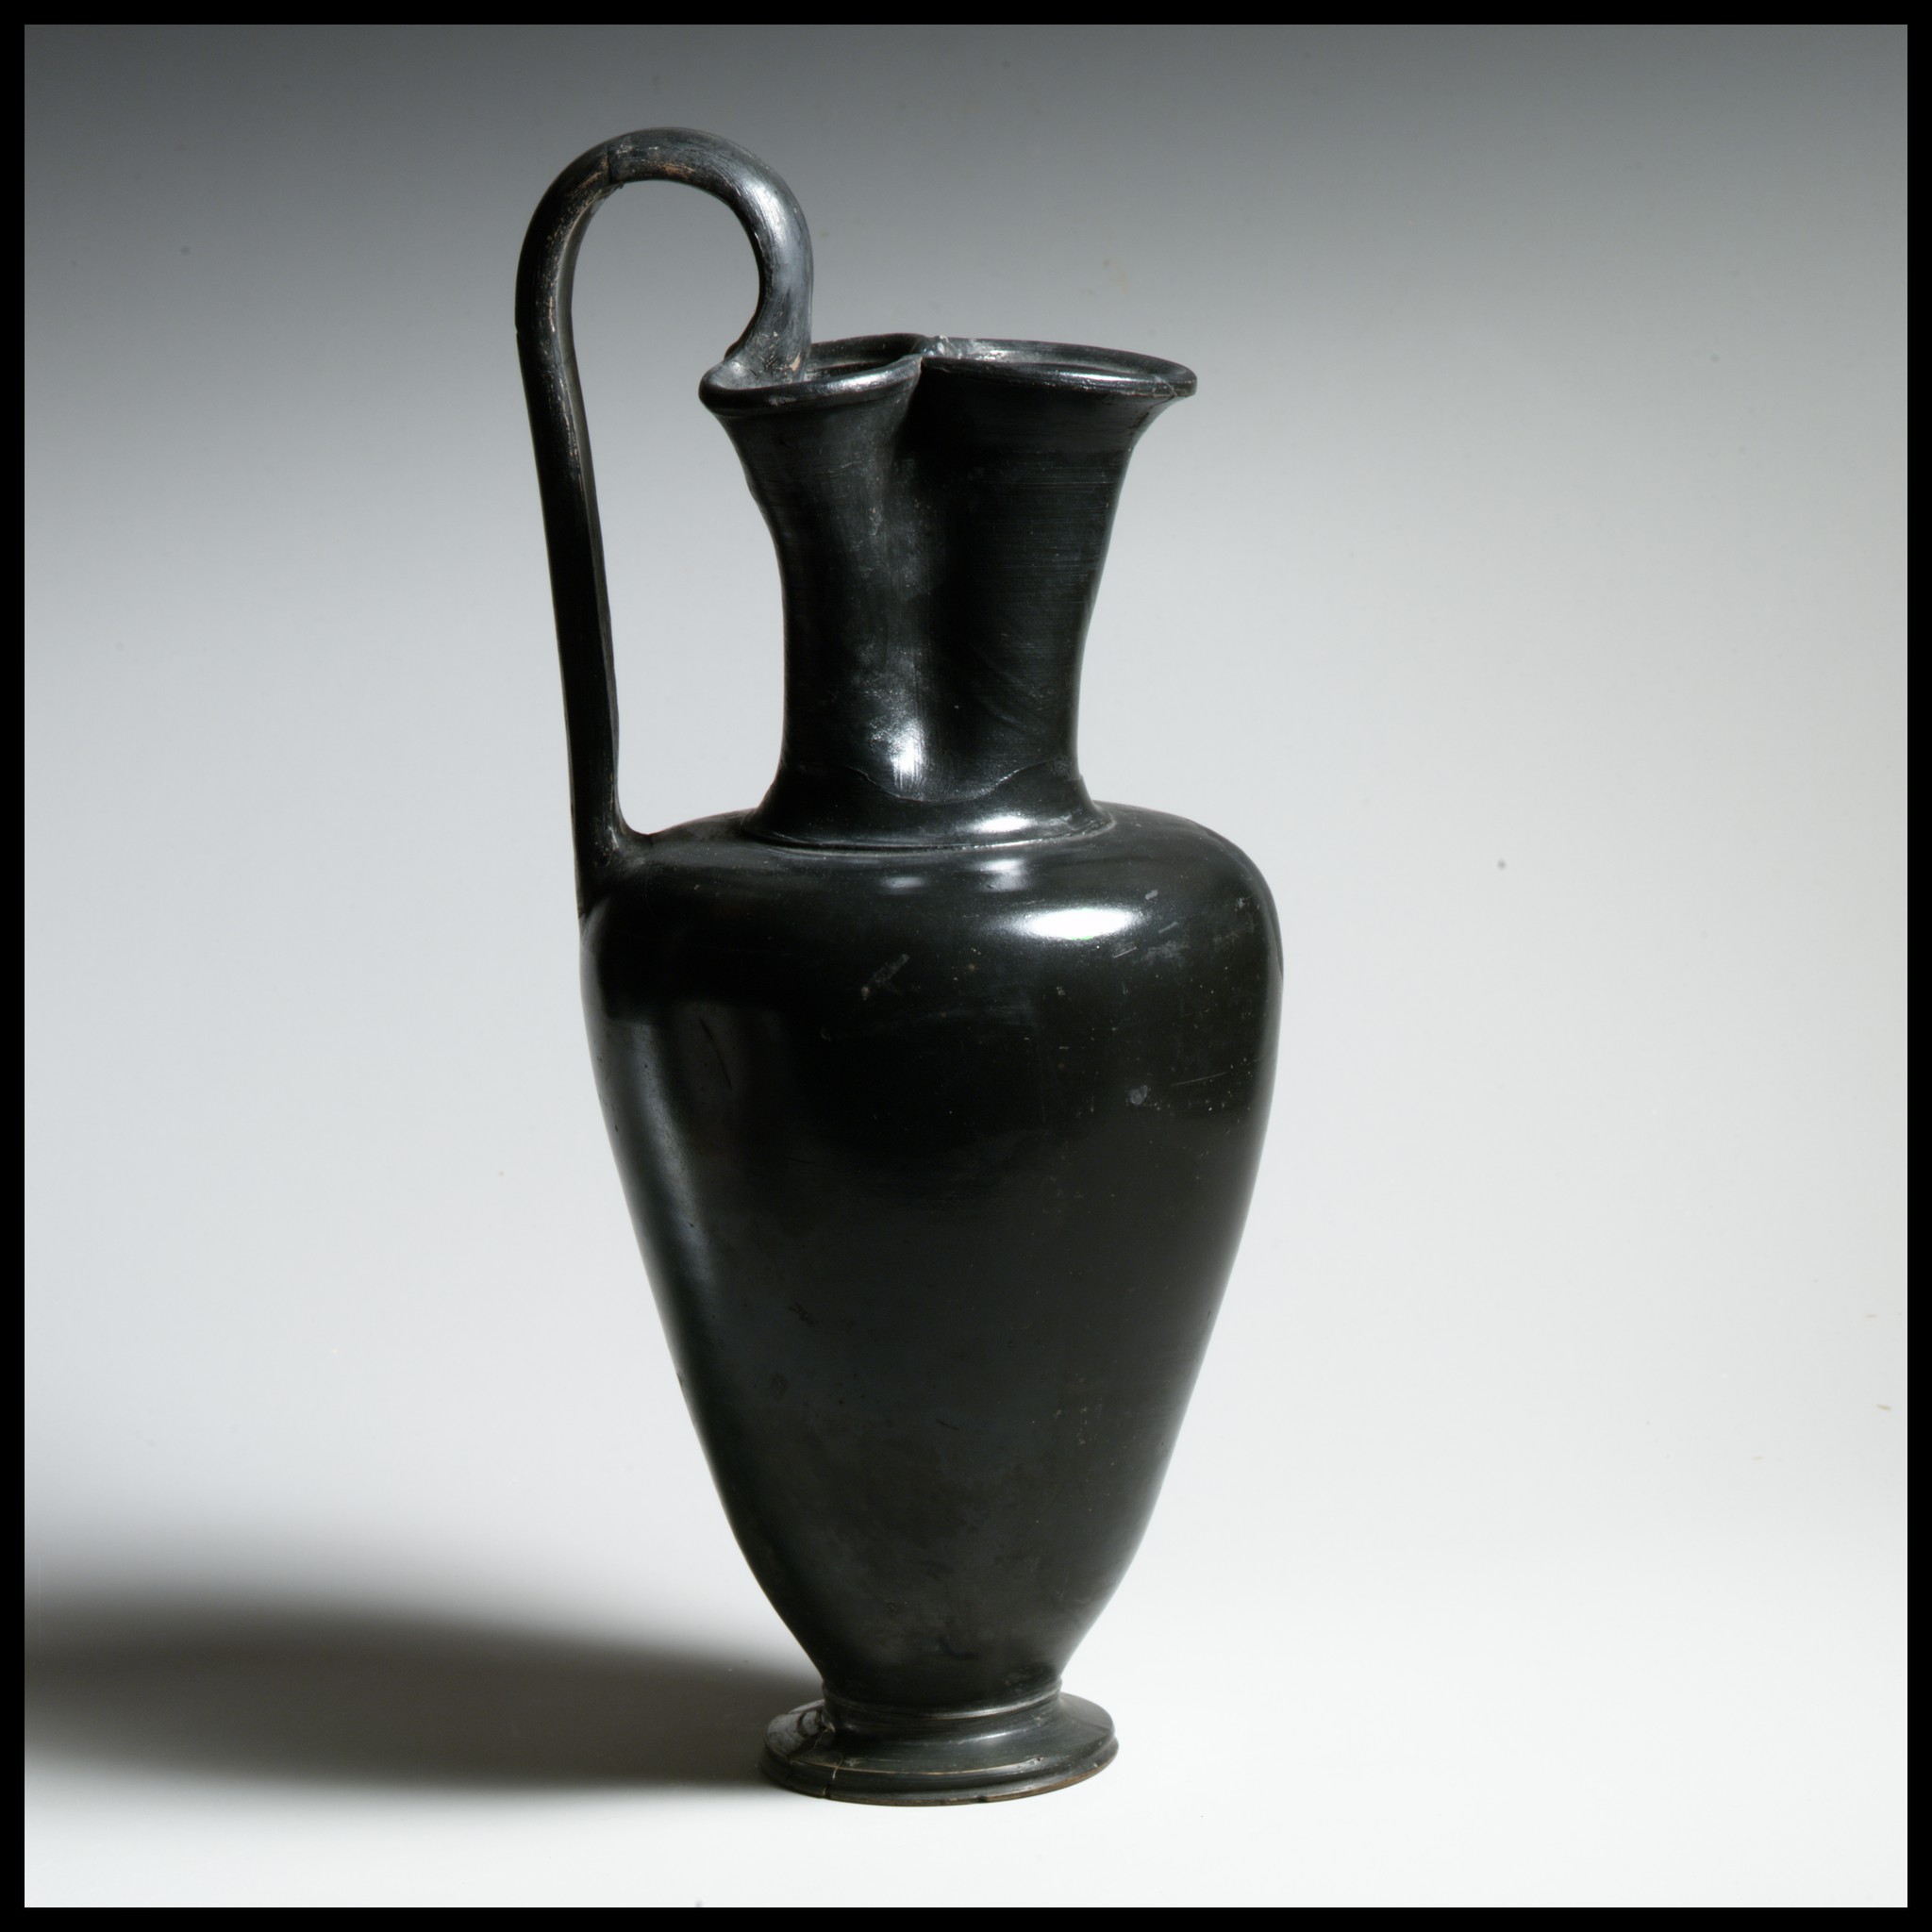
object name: oinochoe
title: Terracotta oinochoe (jug)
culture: greek or south italian or campanian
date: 400-301 BCE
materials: terracotta